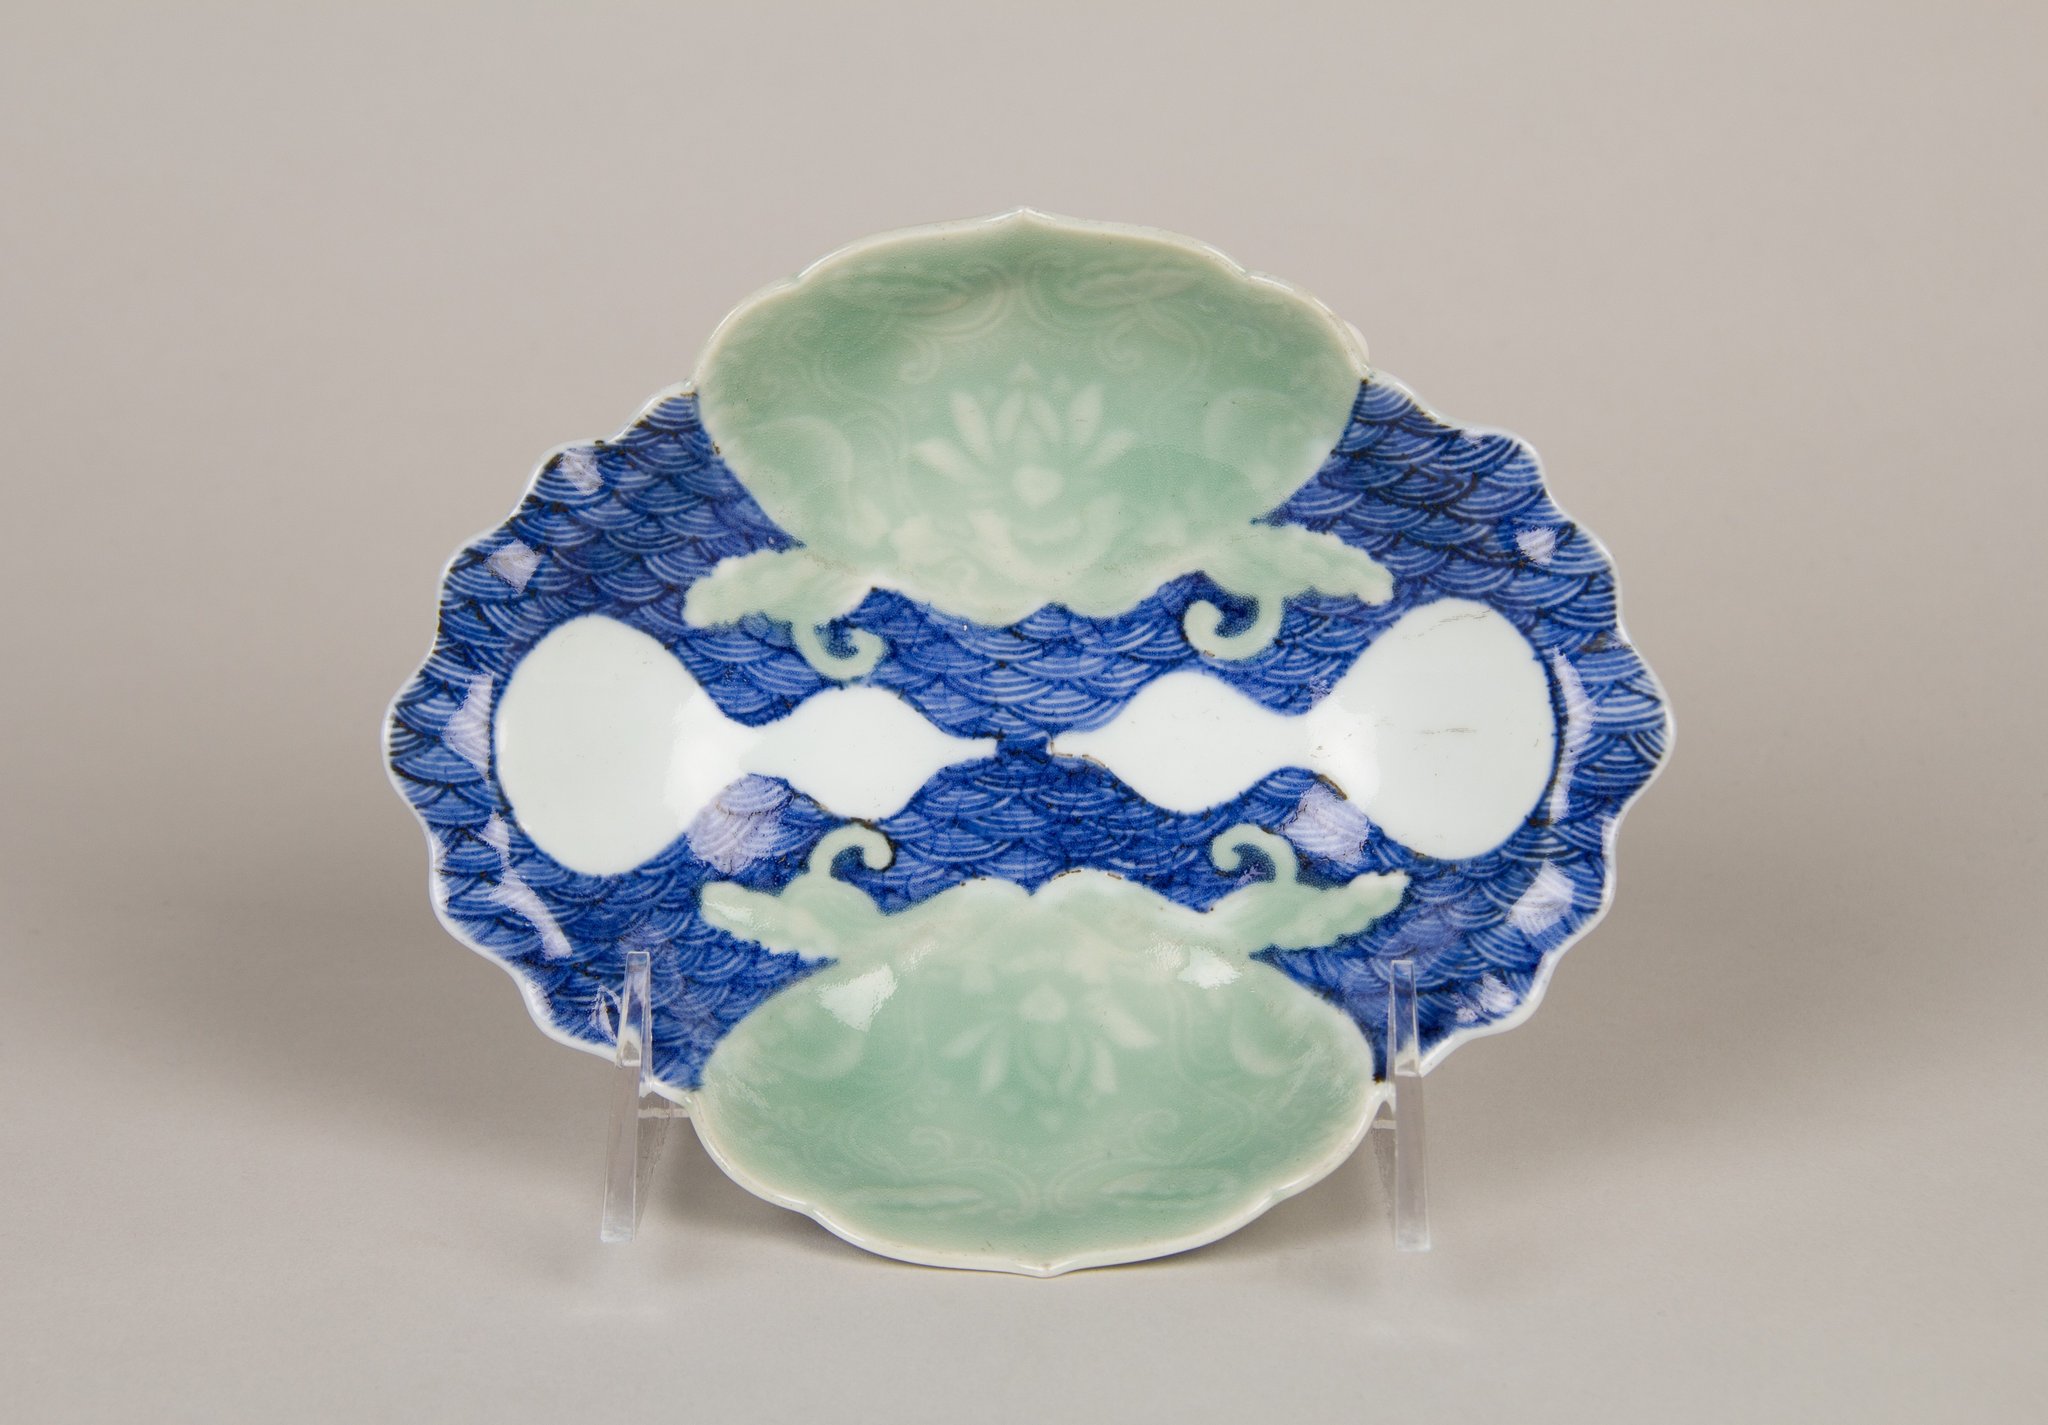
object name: dish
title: Small Dish with Waves, Shells, and Gourds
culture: japanese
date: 1660-1690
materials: ceramic glaze, glaze, porcelain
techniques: underglaze